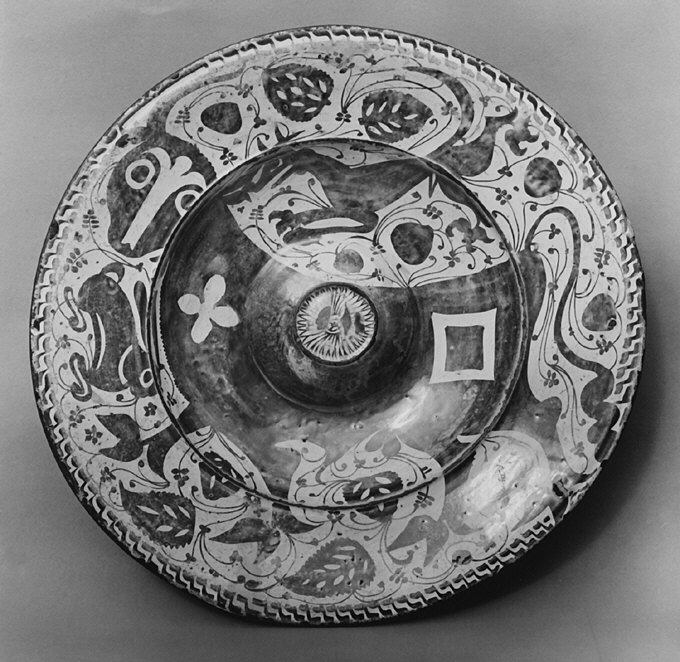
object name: dish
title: Dish with a bull, a greyhound, and a hare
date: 1501-1700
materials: earthenware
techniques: luster painting, glazing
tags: bulls